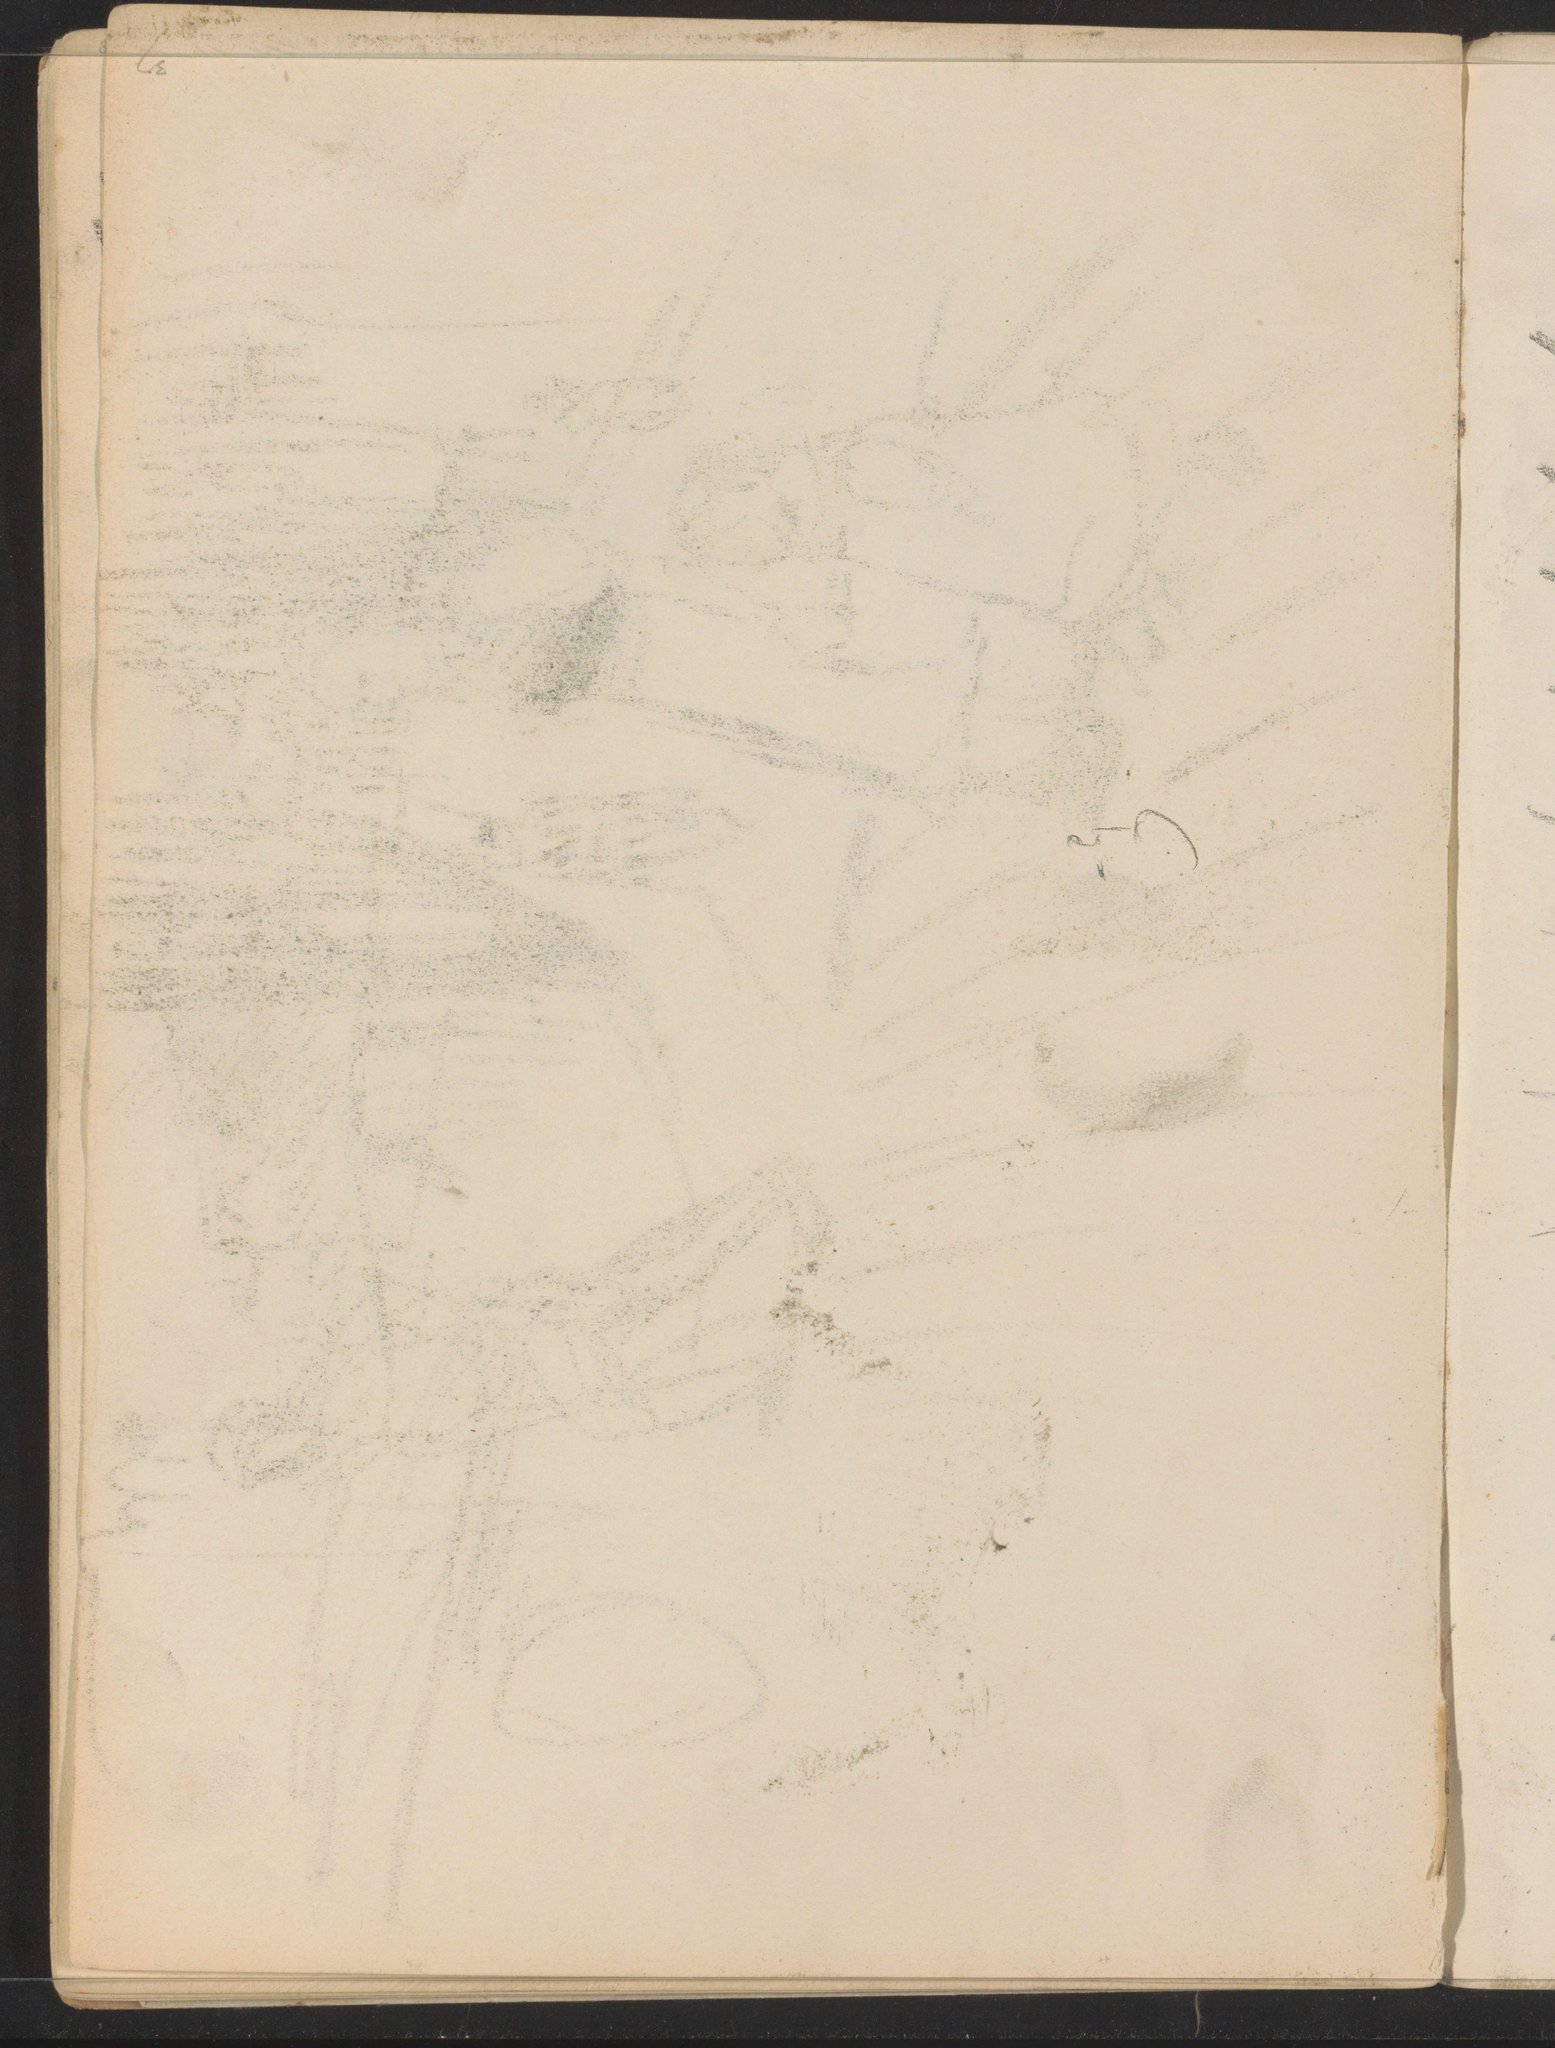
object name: sketchbook leaf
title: Studie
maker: isaac israels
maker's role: draughtsman, painter, print maker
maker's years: 1865-1934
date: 1886-1934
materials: chalk, paper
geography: amsterdam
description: Blad 14 verso uit schetsboek LXVI-B met 25 bladen.